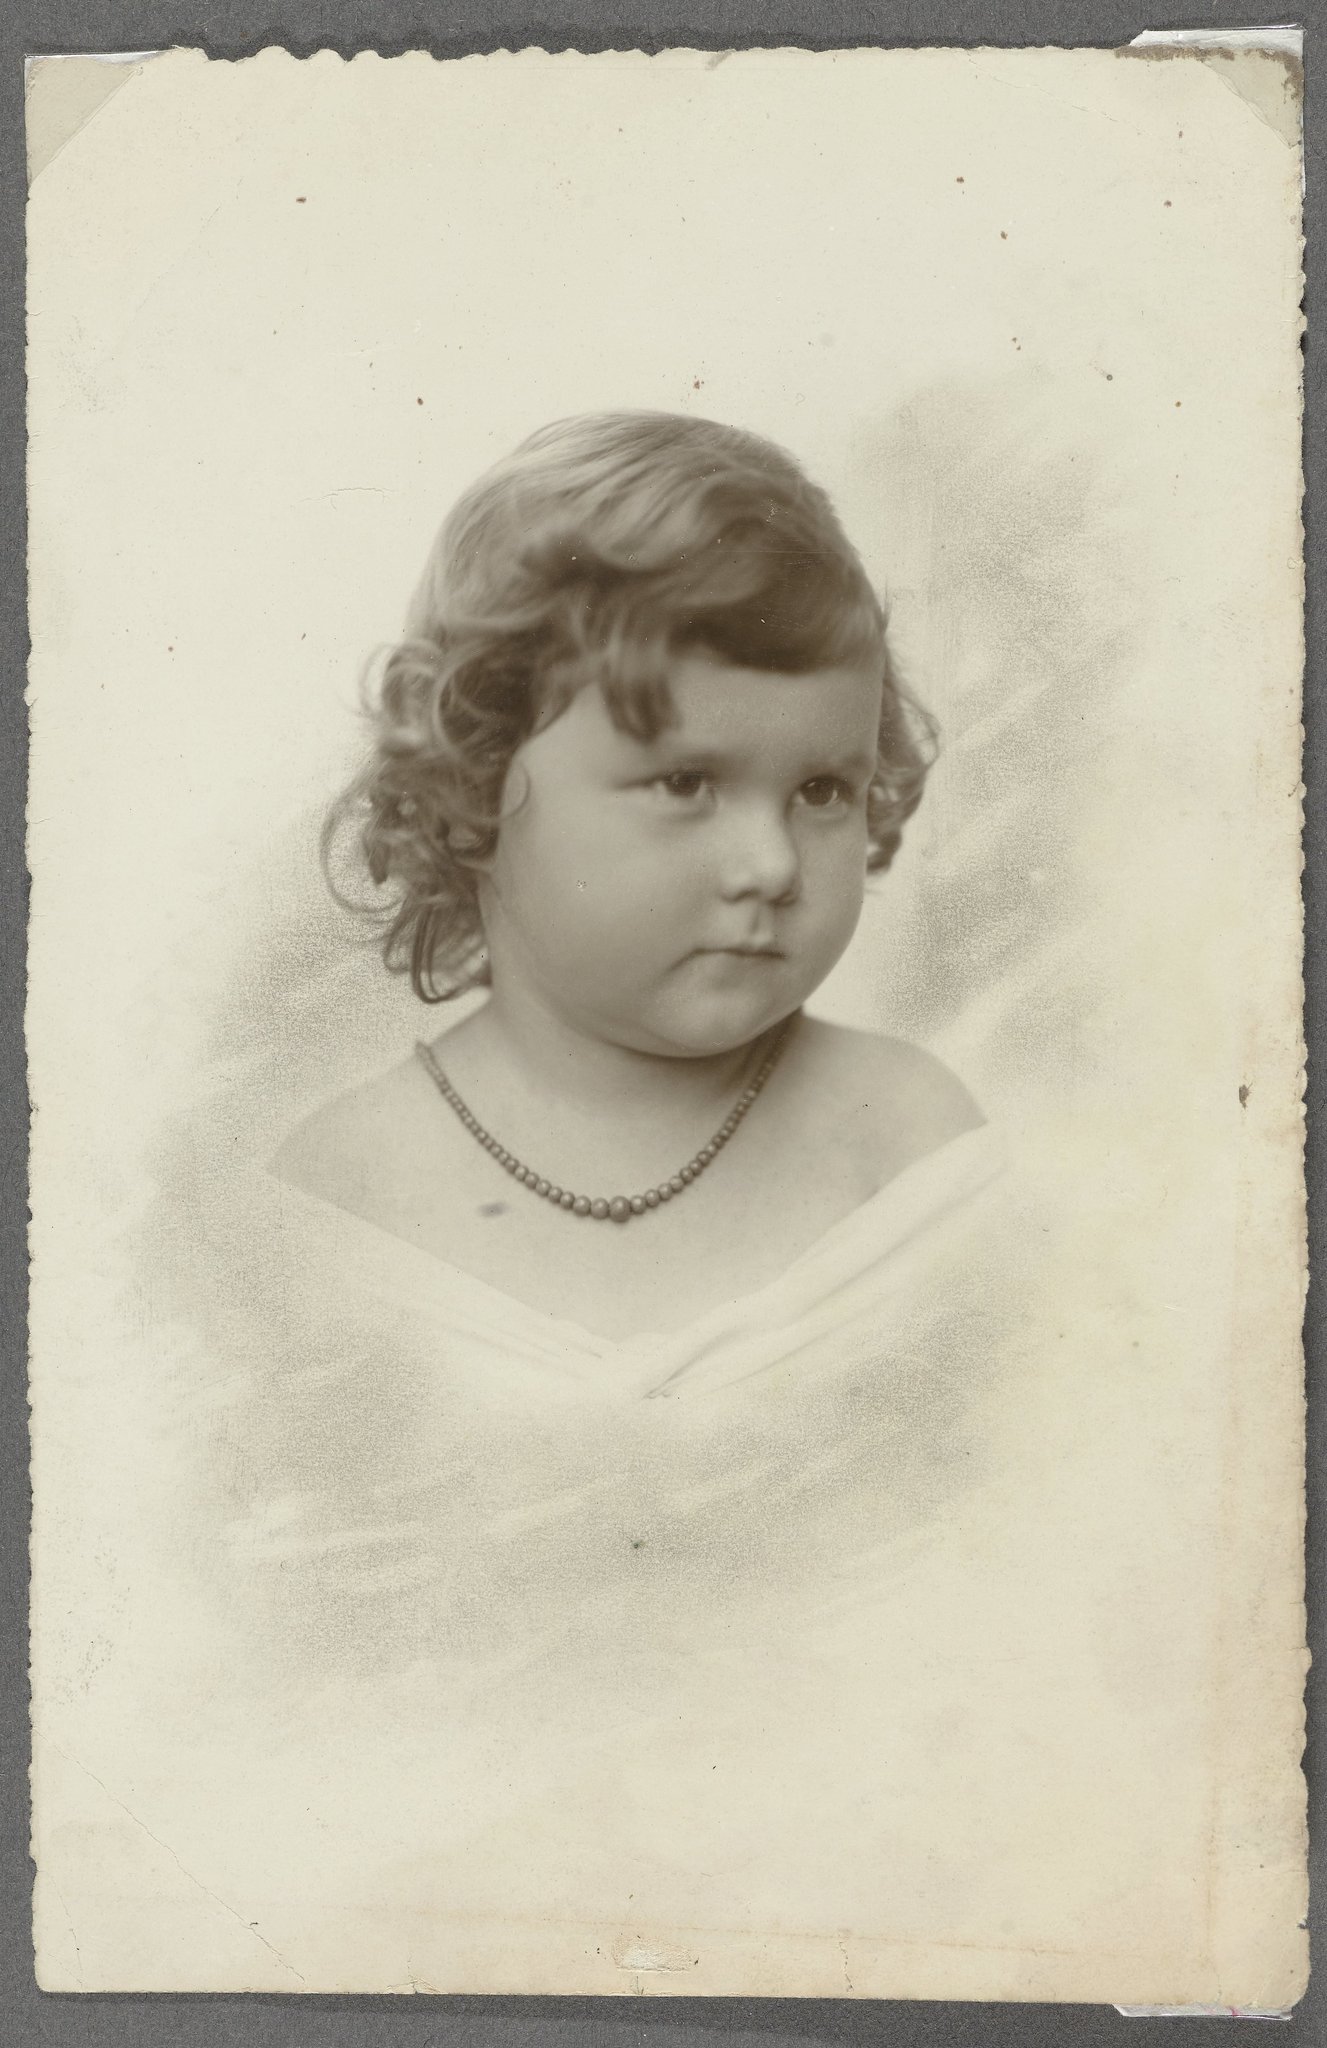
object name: photograph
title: Portret van Tiny Kleiterp als kleuter, met een halsketting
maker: klaas kleiterp (i)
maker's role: arts, officier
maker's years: 1892-1943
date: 1924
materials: paper, photographic support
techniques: gelatin silver print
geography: dutch east indies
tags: child, necklace, dutch east indies, the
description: Onderdeel van Fotoalbum van de familie Kleiterp-Vermeulen met opnames van de kinderen Klaas en Tiny in Nederlands-Indië.